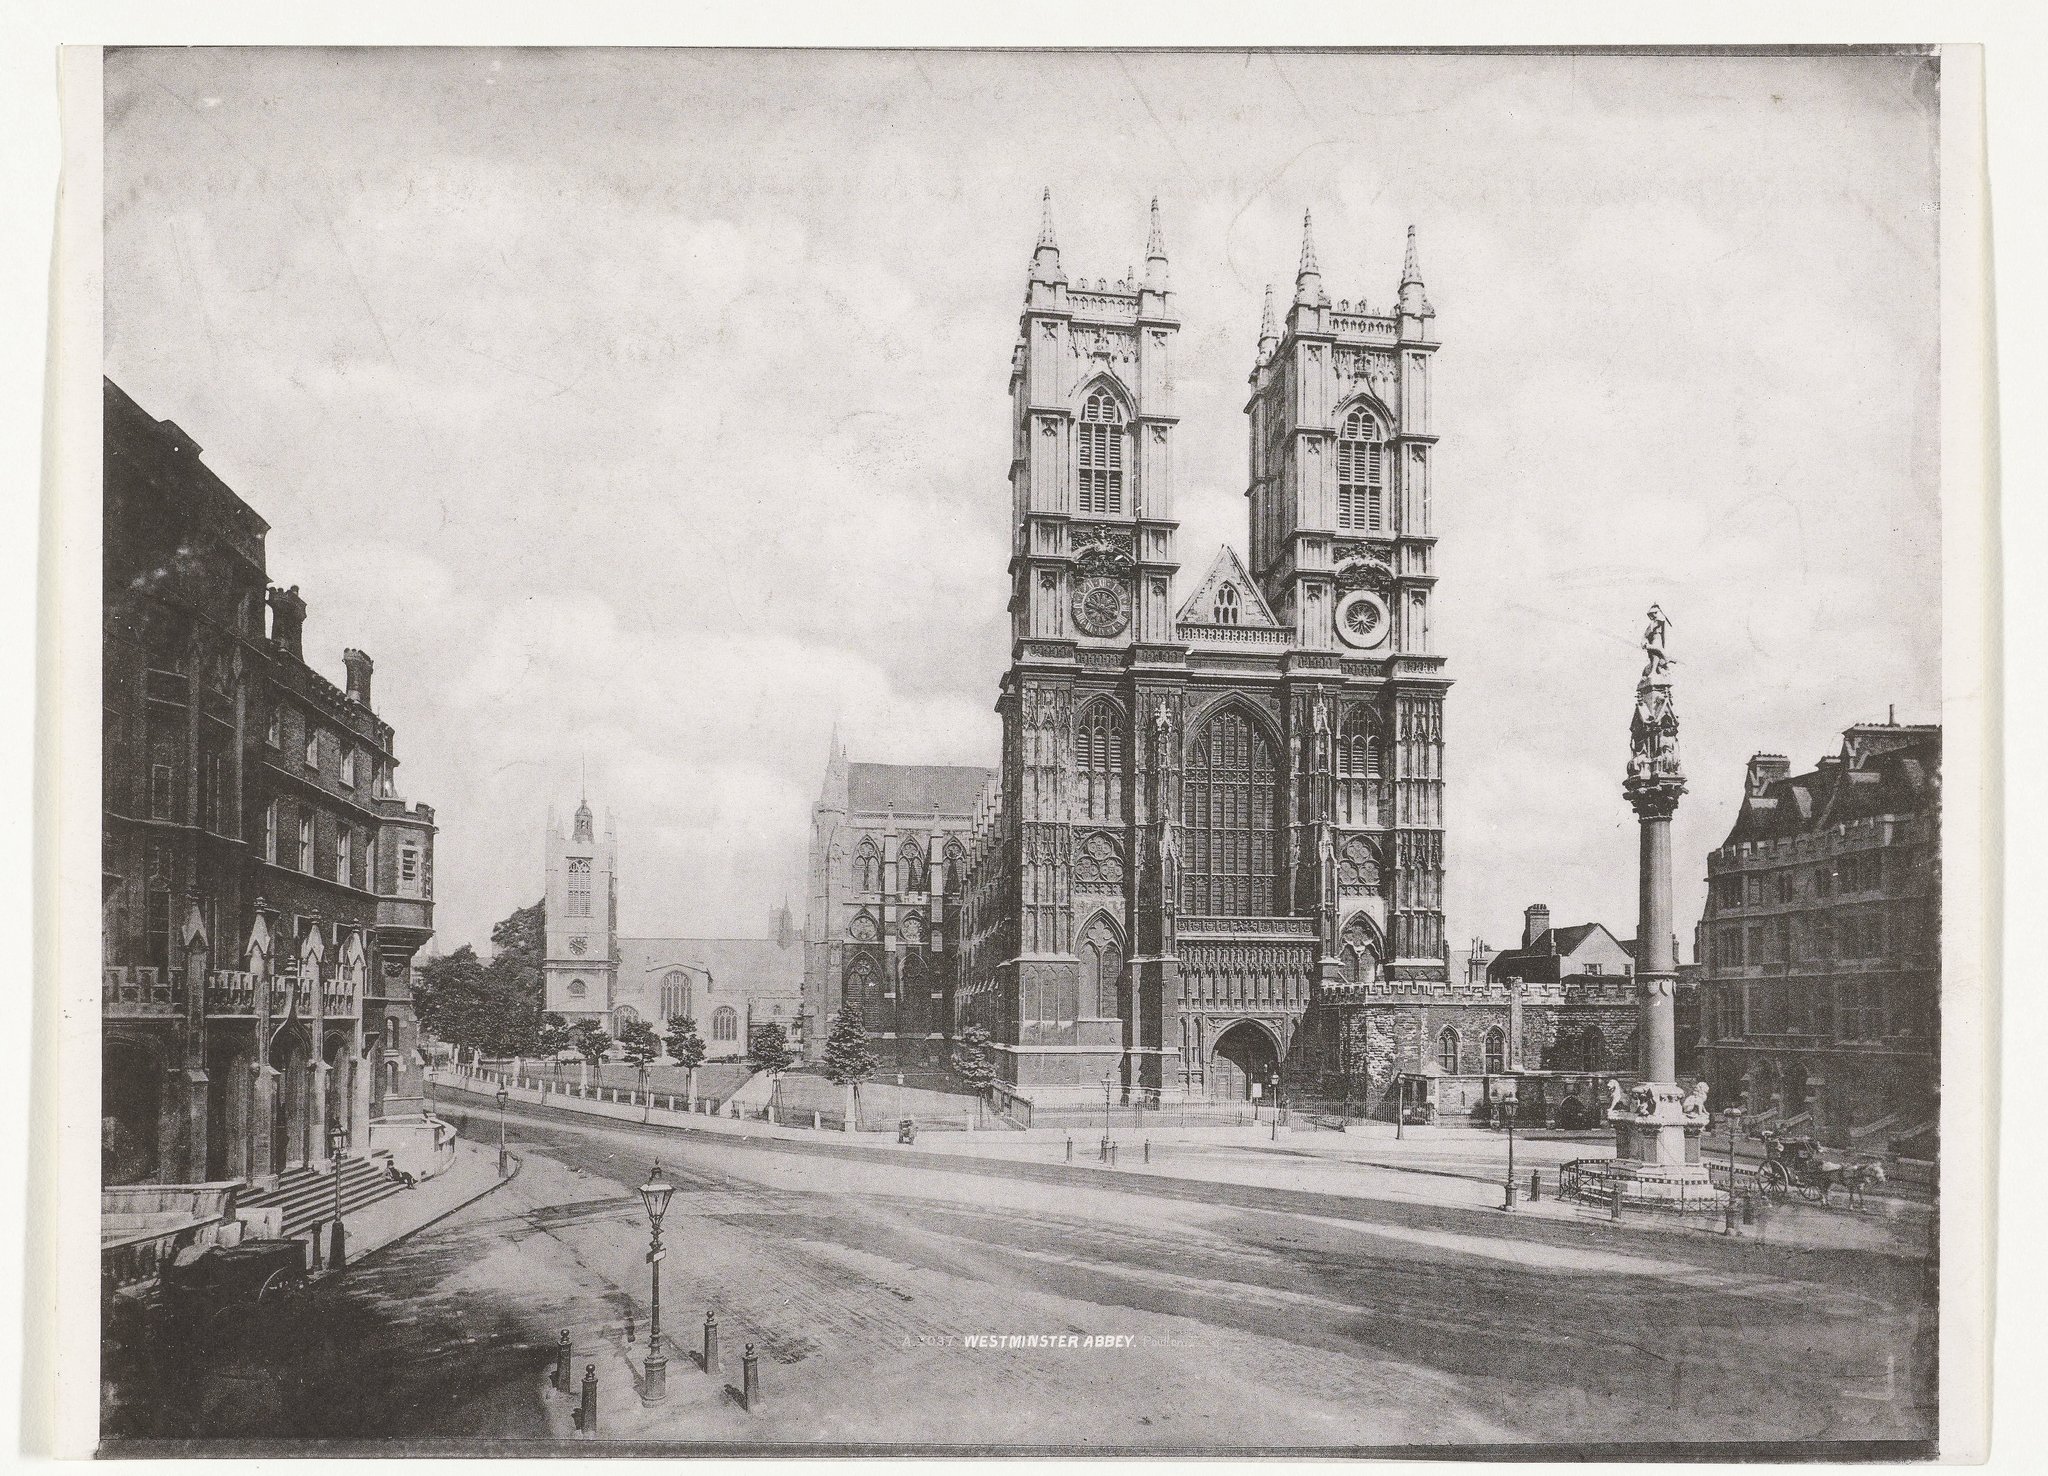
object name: photomechanical print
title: Westminster Abbey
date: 1870-1888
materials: paper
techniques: photograph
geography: london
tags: church (exterior), westminster abbey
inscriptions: number: ‘A.2037 [?]’